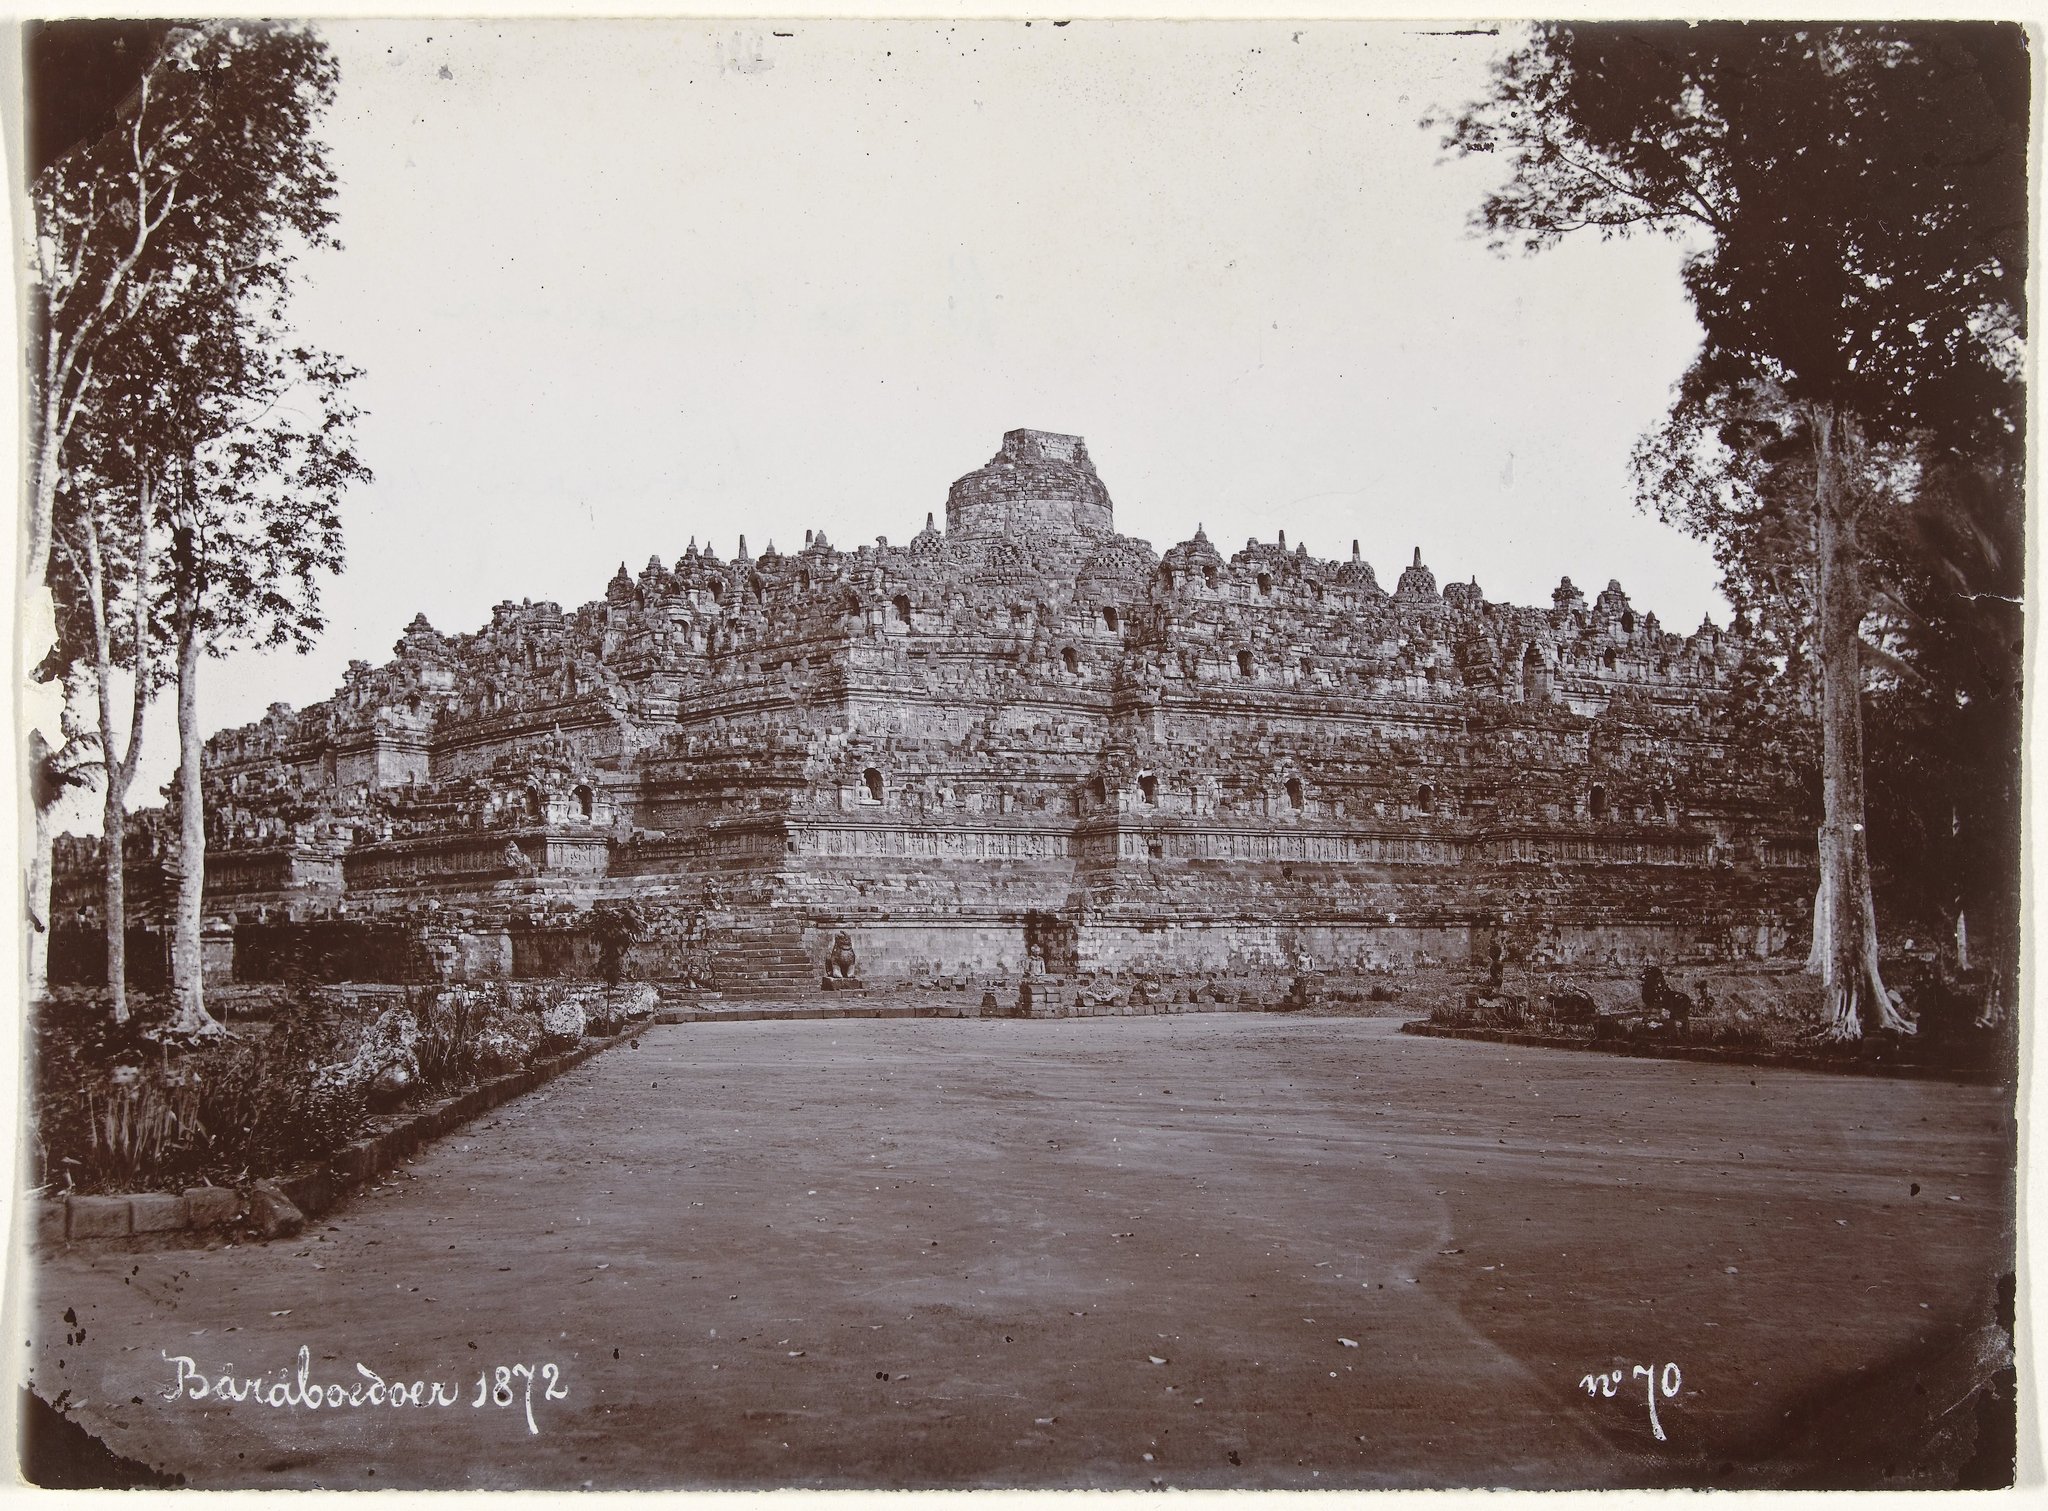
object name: photograph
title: Baraboedoer 1872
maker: kassian céphas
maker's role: fotograaf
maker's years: 1845-1912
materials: paper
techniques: gelatin silver print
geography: java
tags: temple, shrine ~ hinduism, buddhism, jainism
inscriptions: inscription: ‘Boroboedoer/ februari 1904’, number: ‘26’, inscription: ‘Boroboedoer 1872/ no 70’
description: Mogelijk is deze foto genomen in 1872 en is de afdruk gemaakt of gekocht in 1904.